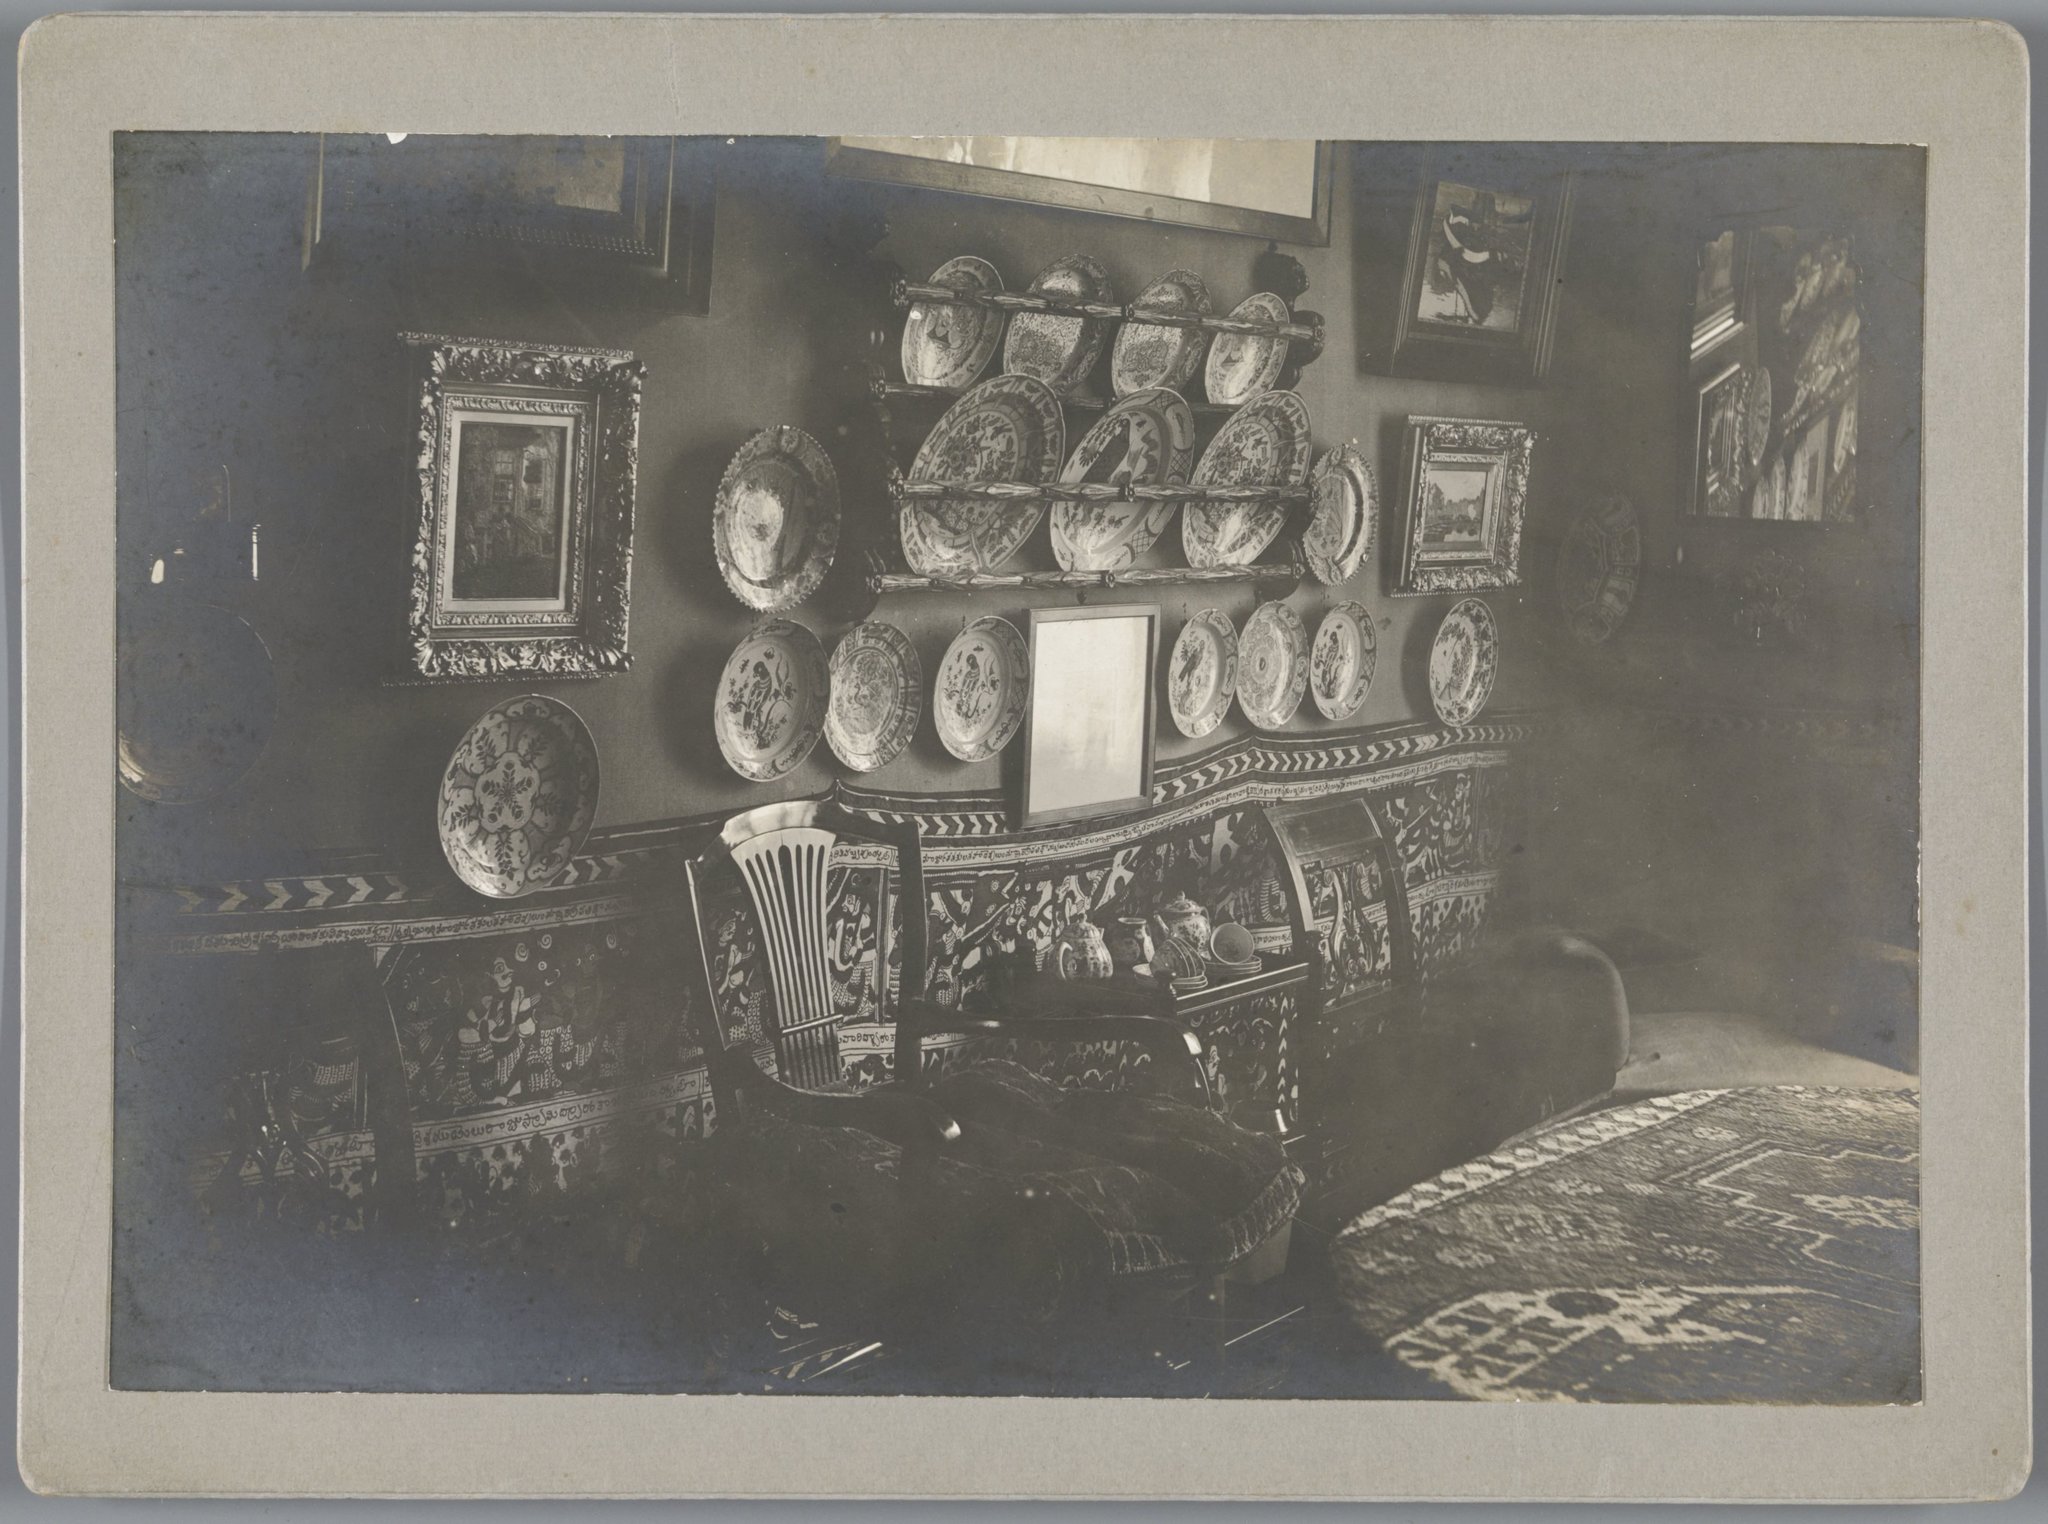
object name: photograph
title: Interieur Witsen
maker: willem witsen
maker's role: draughtsman, painter, print maker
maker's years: 1860-1923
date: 1860-1915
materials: cardboard, paper, photographic support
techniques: gelatin silver print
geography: amsterdam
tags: witsenhuis